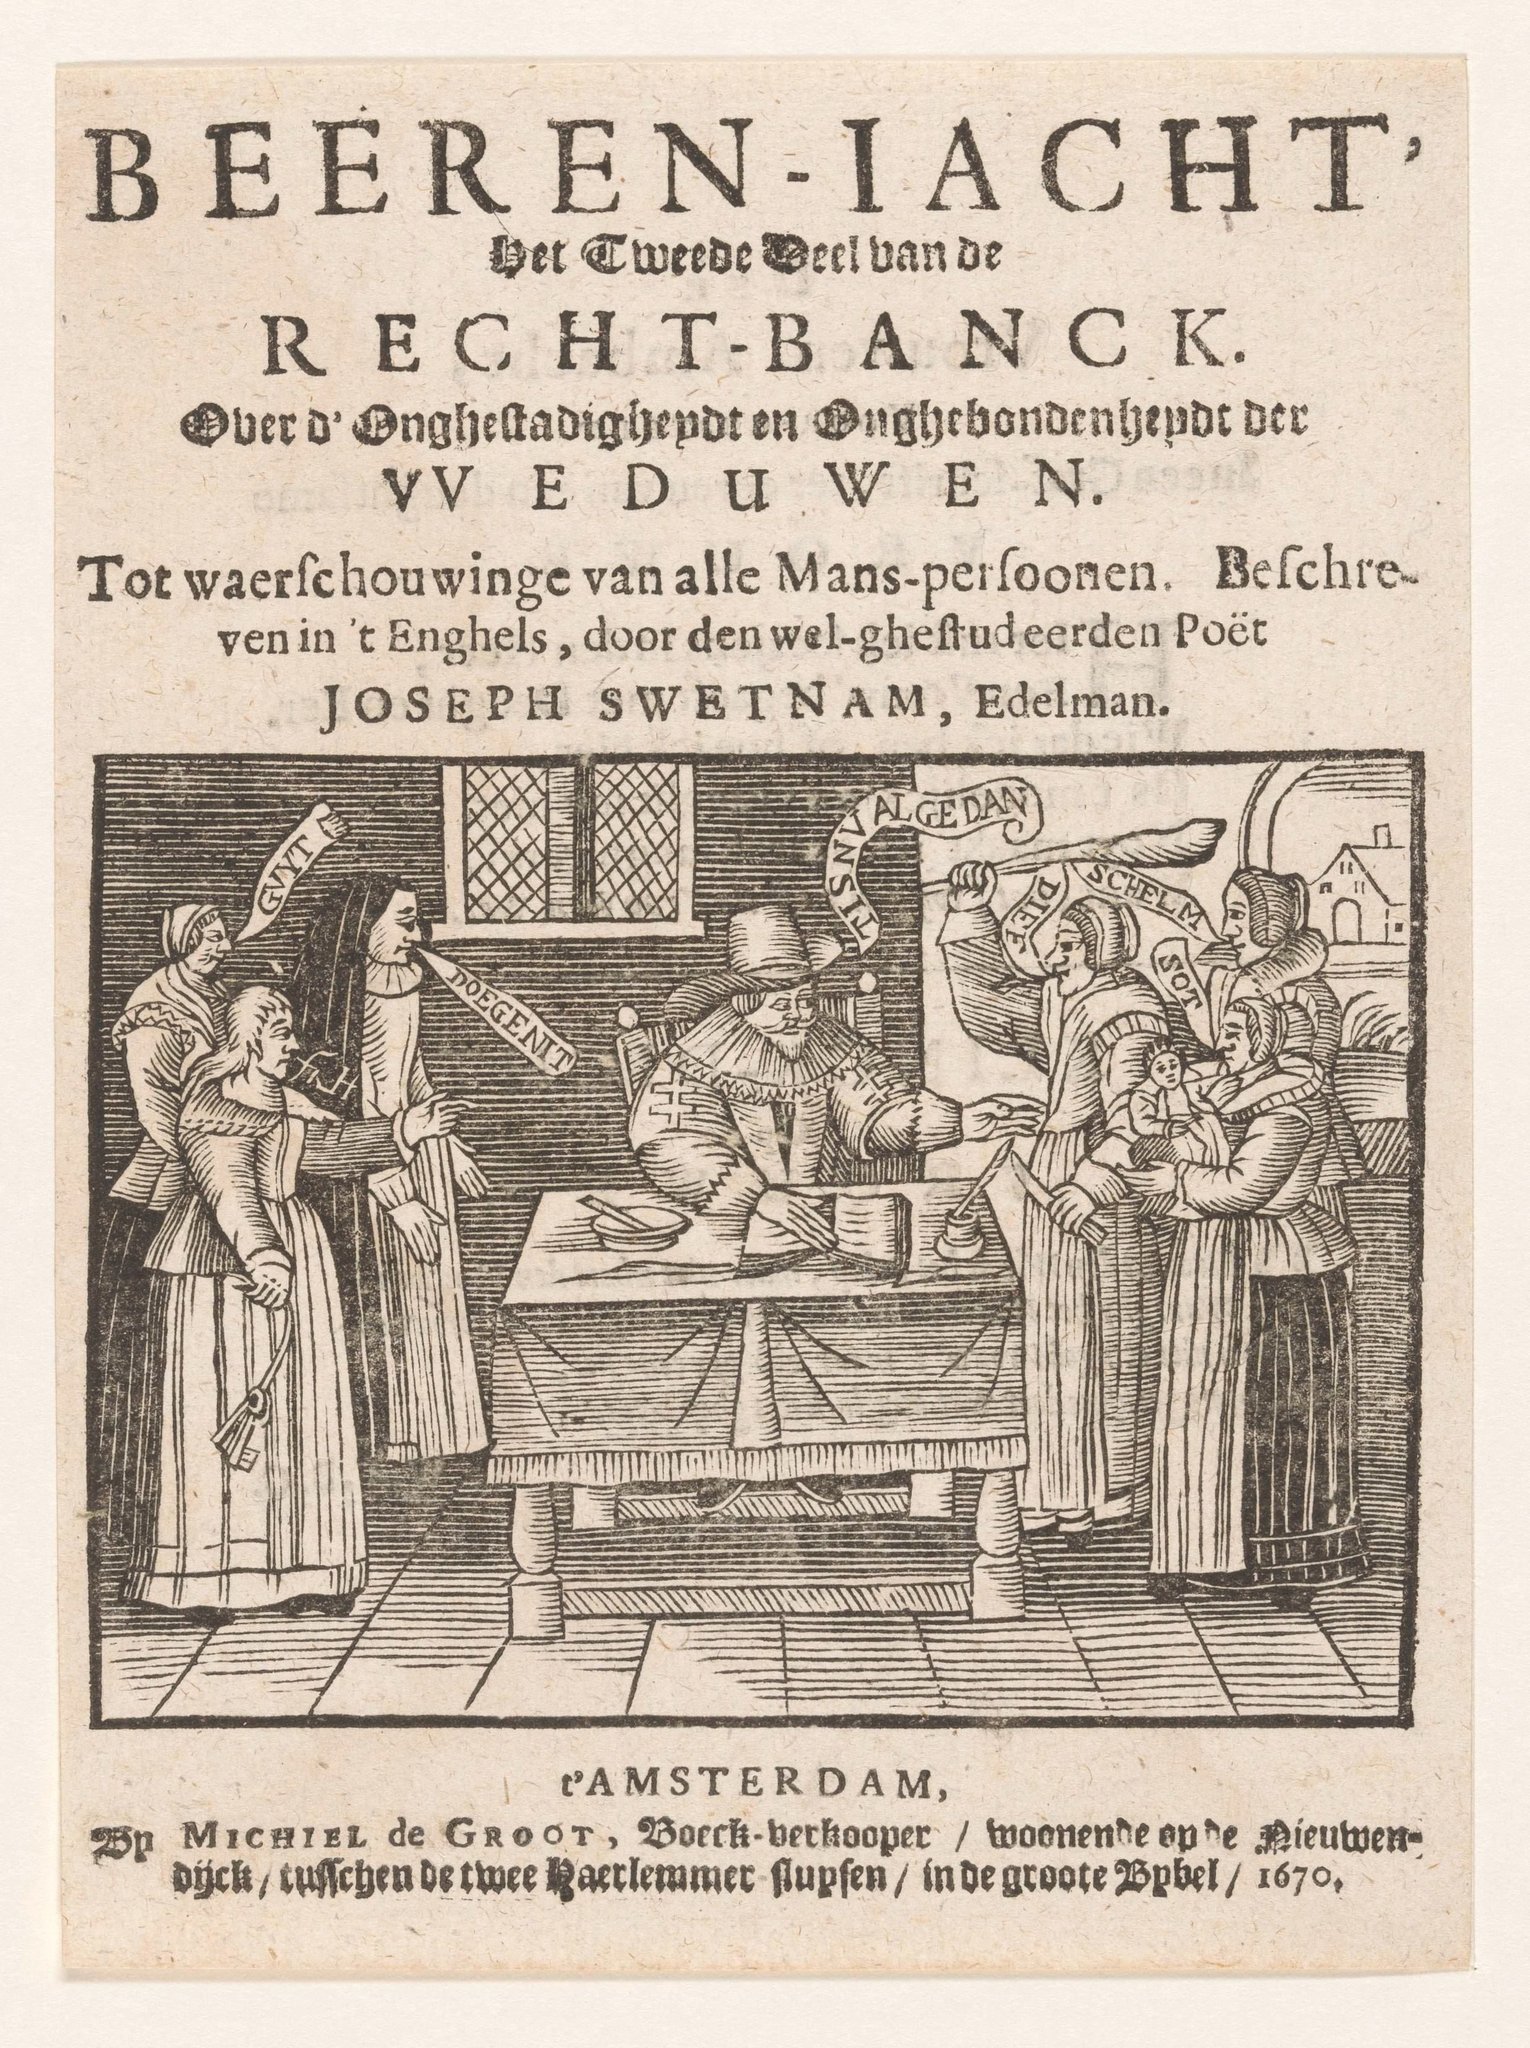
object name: titelblad, titelpagina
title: Boze vrouwen rondom schrijver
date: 1670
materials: paper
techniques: letterpress printing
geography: amsterdam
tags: writer, poet, author, rage, anger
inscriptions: collector's mark: Lugt 2760, collector's mark: Lugt 2228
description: De auteur van het boek zit aan tafel en legt zijn rechterhand op een boek. Rondom staan twee groepen boze vrouwen die hem uitmaken voor onder andere doegenit (deugniet), schelm en sot (zot). De auteur antwoordt: Tis nu al gedan.